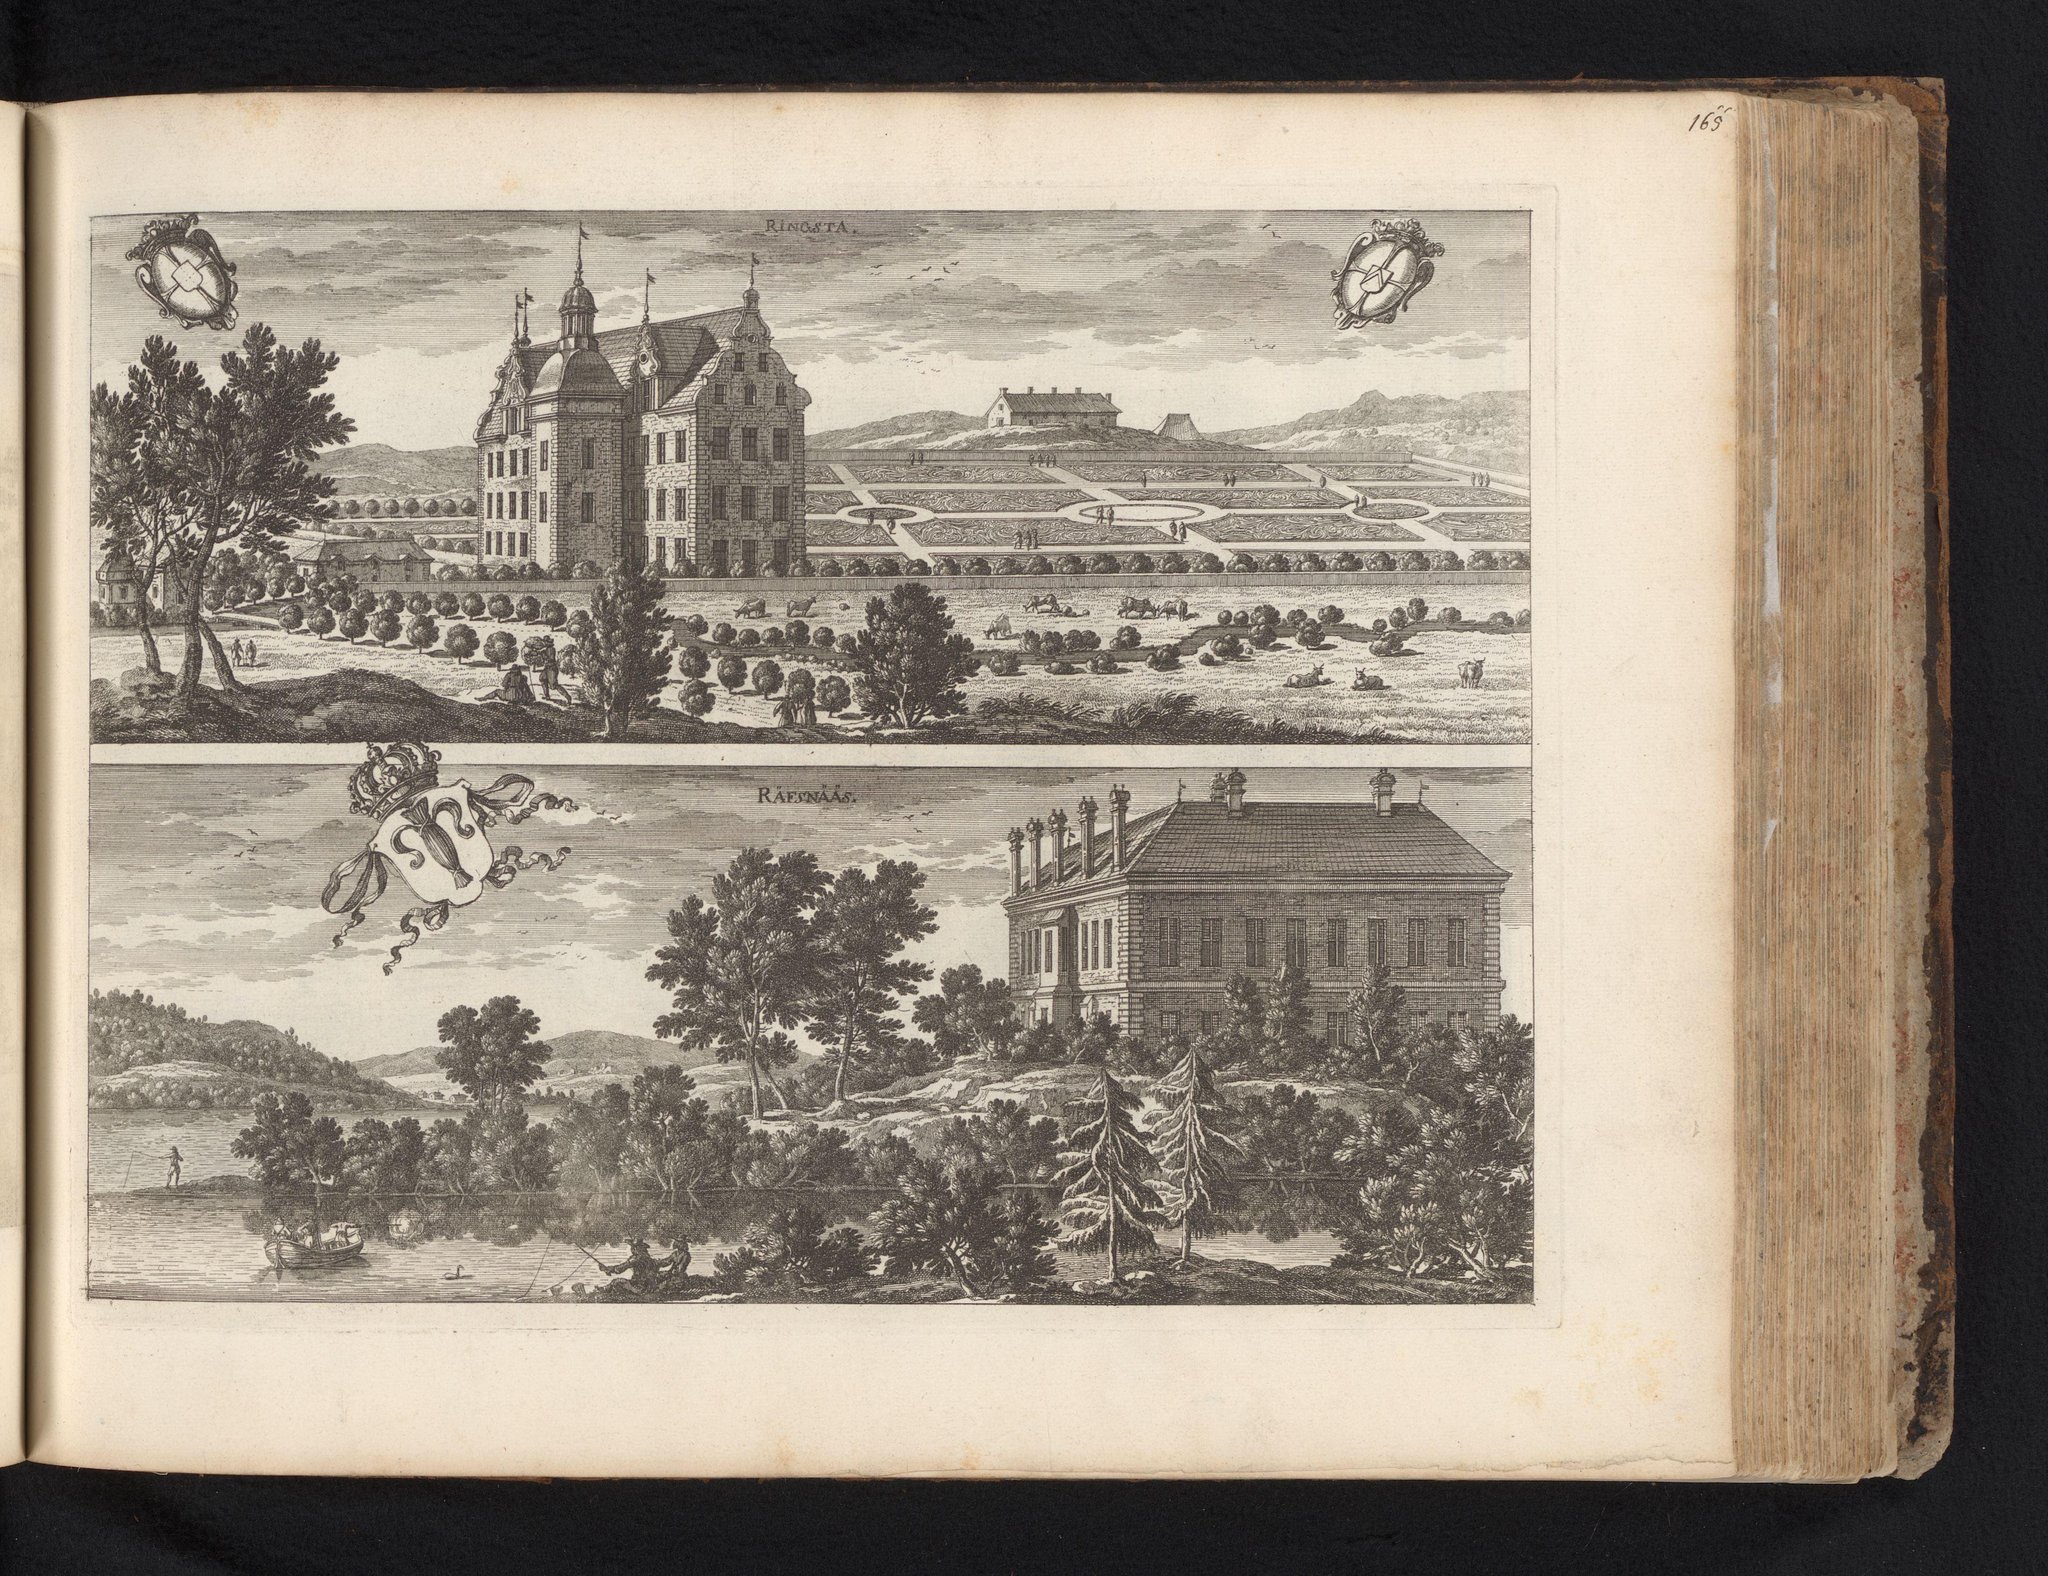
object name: album leaf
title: Gezicht op slot Rinkesta en herenhuis Räfsnäs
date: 1670-1674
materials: paper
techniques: etching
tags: housing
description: Kungliga Biblioteket, 'Suecia': http://www.kb.se/samlingarna/Kartor-bilder/Suecia-antiqua/ (geraadpleegd november 2016).